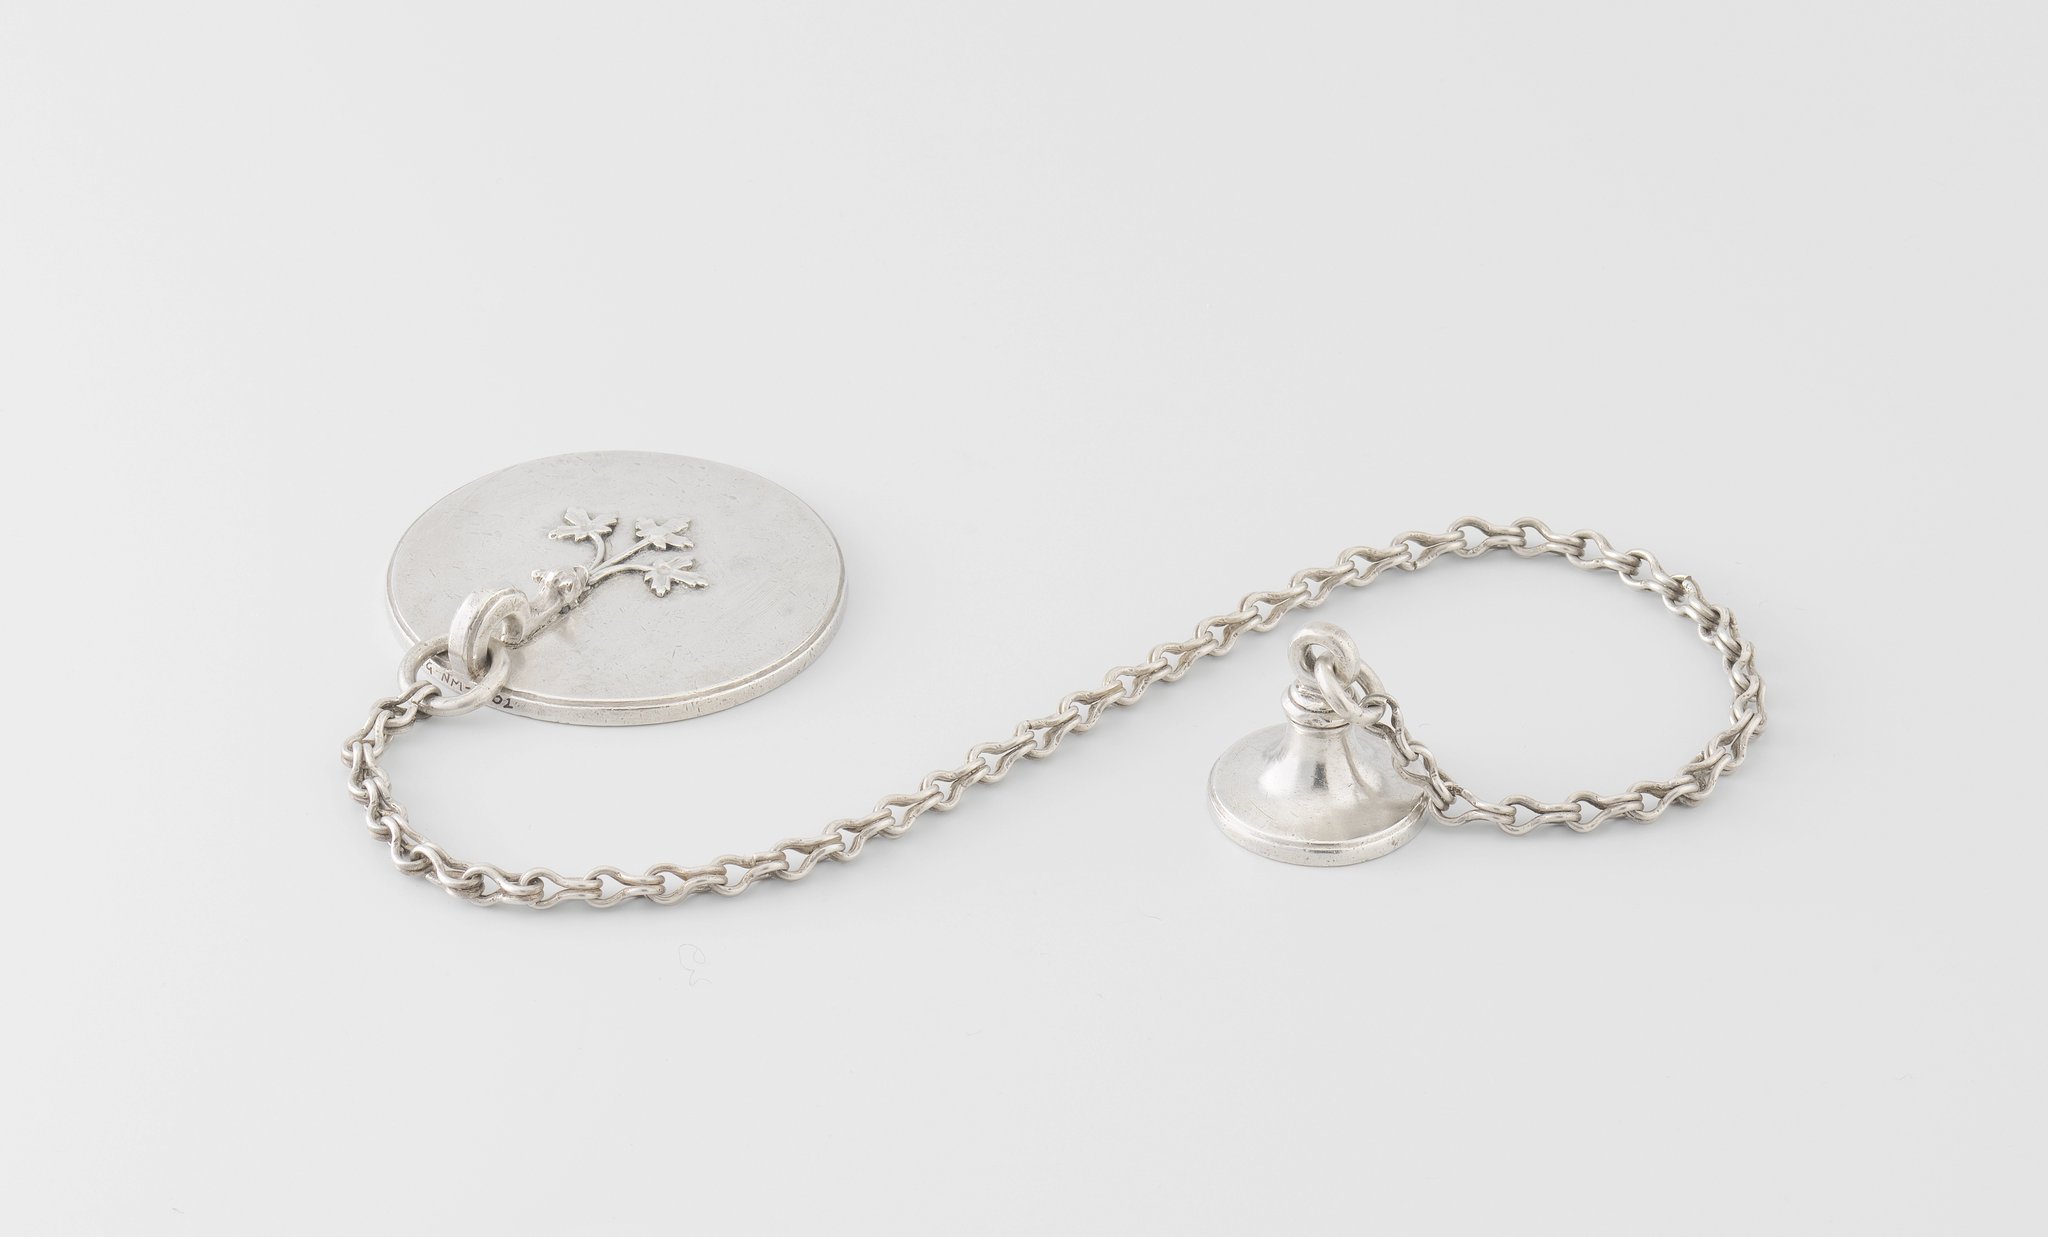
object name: stamp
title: Seal stamp and counterseal stamp of Wolfert van Borselen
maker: Anonymous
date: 1298-1299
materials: silver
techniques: casting, engraving, forging, striking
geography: zeeland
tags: foliage ~ ornament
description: Groot plat, rond zegel waarop geharnast ruiter met schild en getrokken zwaard galloperend naar links. Keerzijde: aan de rand een draagoog uitlopend in een dierenkop in het midden, uit wiens bek drie takken met één (beuken-)blad (?) komen, met grote ring aan de ketting. Aan het andere einde van de ketting aan een draagring en draagoog een contrazegelstempel in de vorm van een cachet, een schild als beeldenaar. Randschrift: ISTVD SIGILVM EST DNI WLFARDI DE BARSALIA MILITIS. contr.: SECRET WLFARDI DE BARSALIA MILIT.